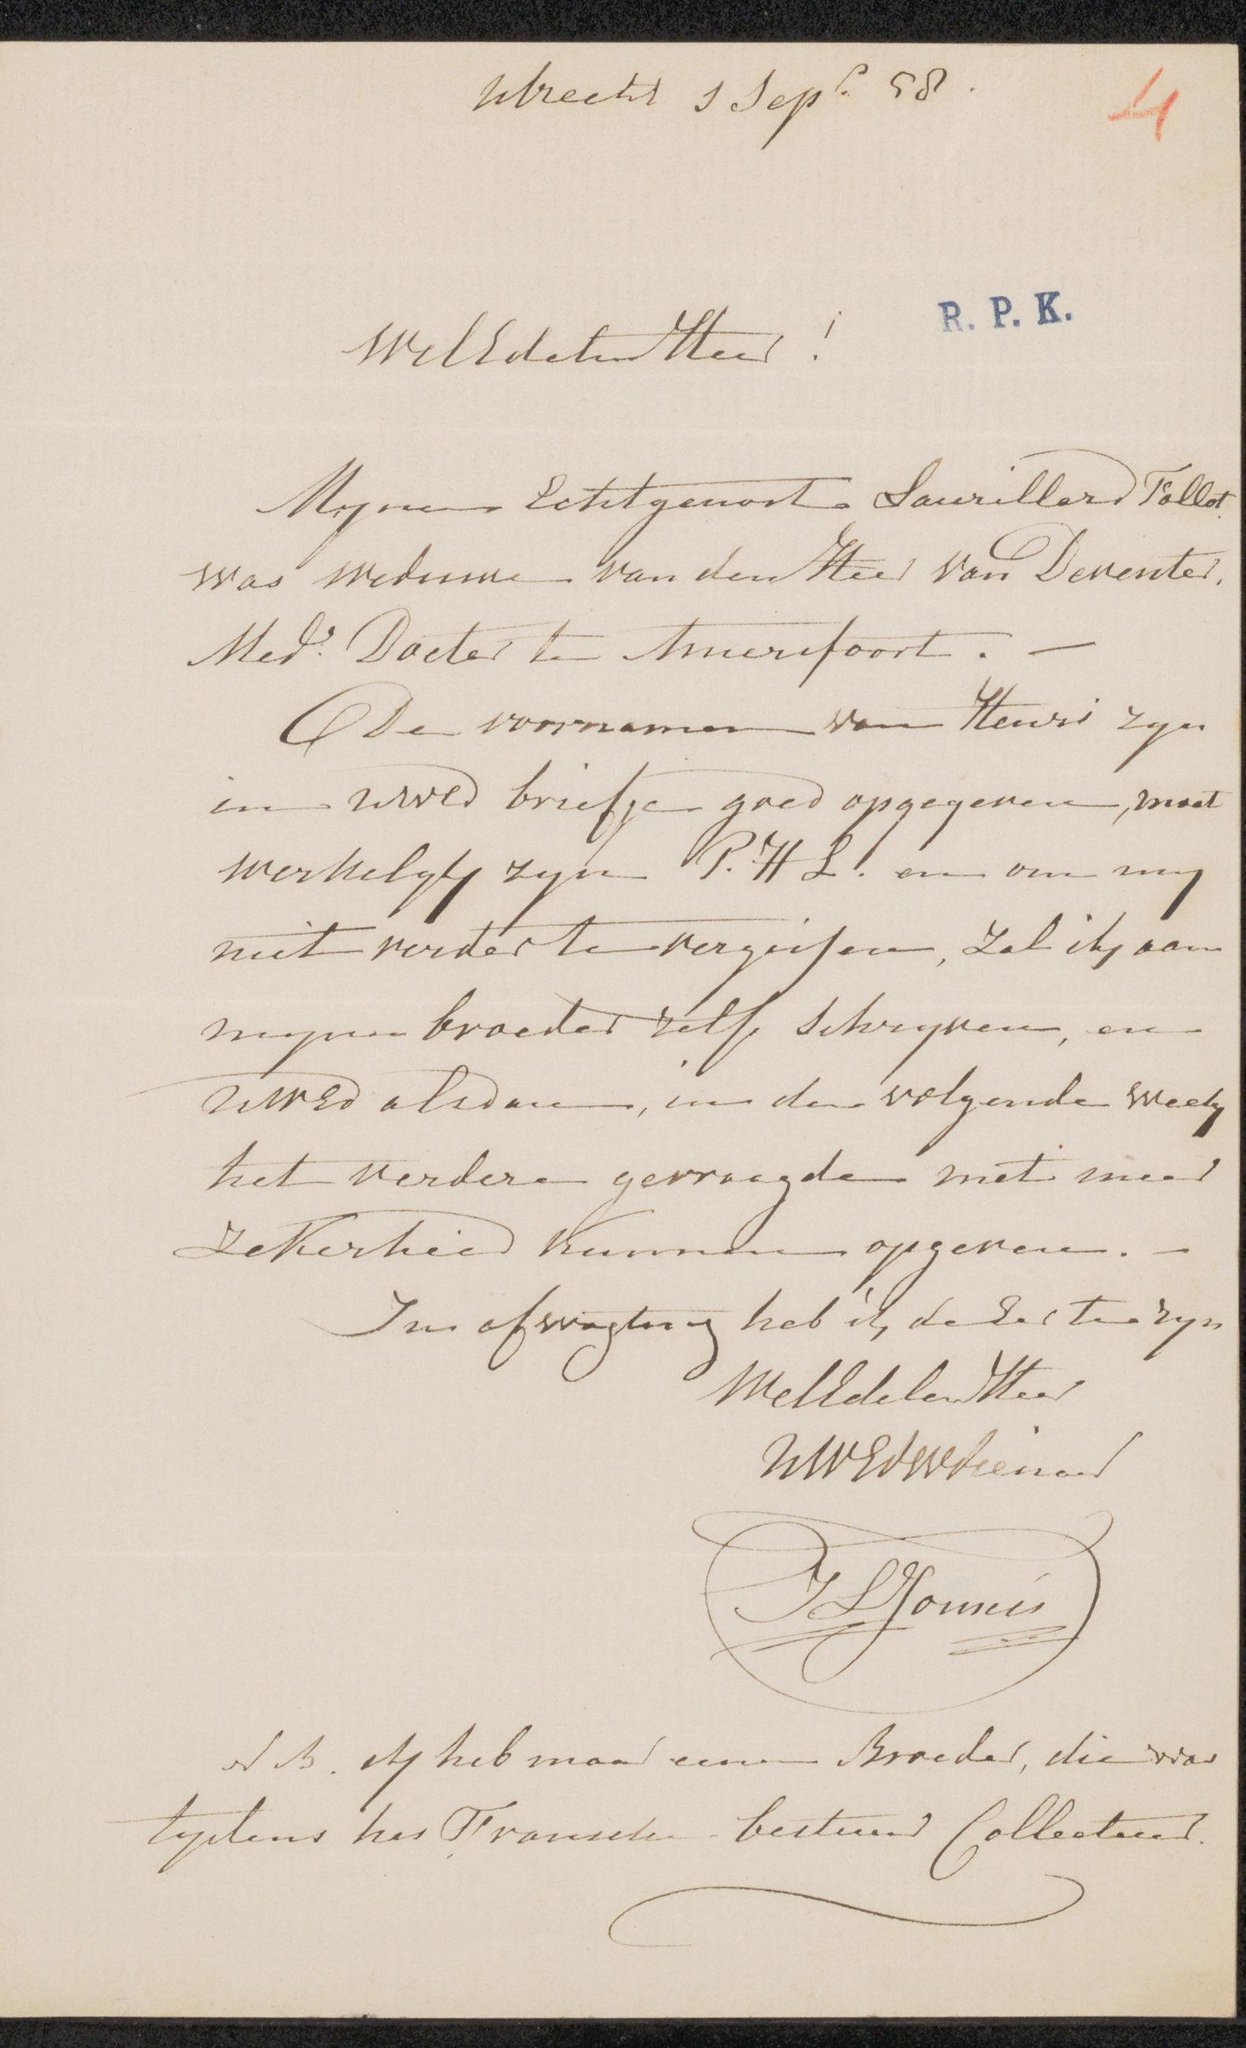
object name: letter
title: Brief aan Christiaan Kramm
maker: jan lodewijk jonxis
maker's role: draughtsman, painter, print maker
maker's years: 1789-1867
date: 1858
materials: ink, paper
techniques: pen, writing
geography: utrecht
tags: brussels, painter, utrecht, print maker, draughtsman, christiaan kramm, family life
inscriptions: collector's mark: Lugt 2233